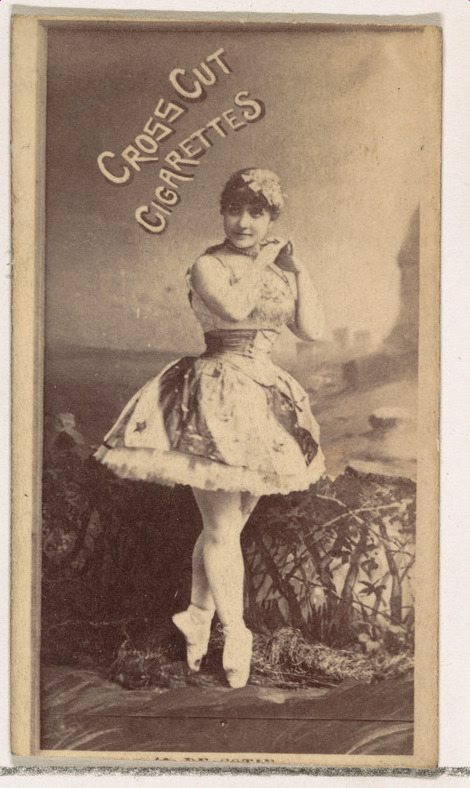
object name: print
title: Ballerina, from the Actors and Actresses series (N145-1) issued by Duke Sons & Co. to promote Cross Cut Cigarettes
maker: w. duke, sons & co.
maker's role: publisher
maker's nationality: american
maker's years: 1870-1920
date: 1880-1889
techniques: albumen silver print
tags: portraits,women,dancers,ballet